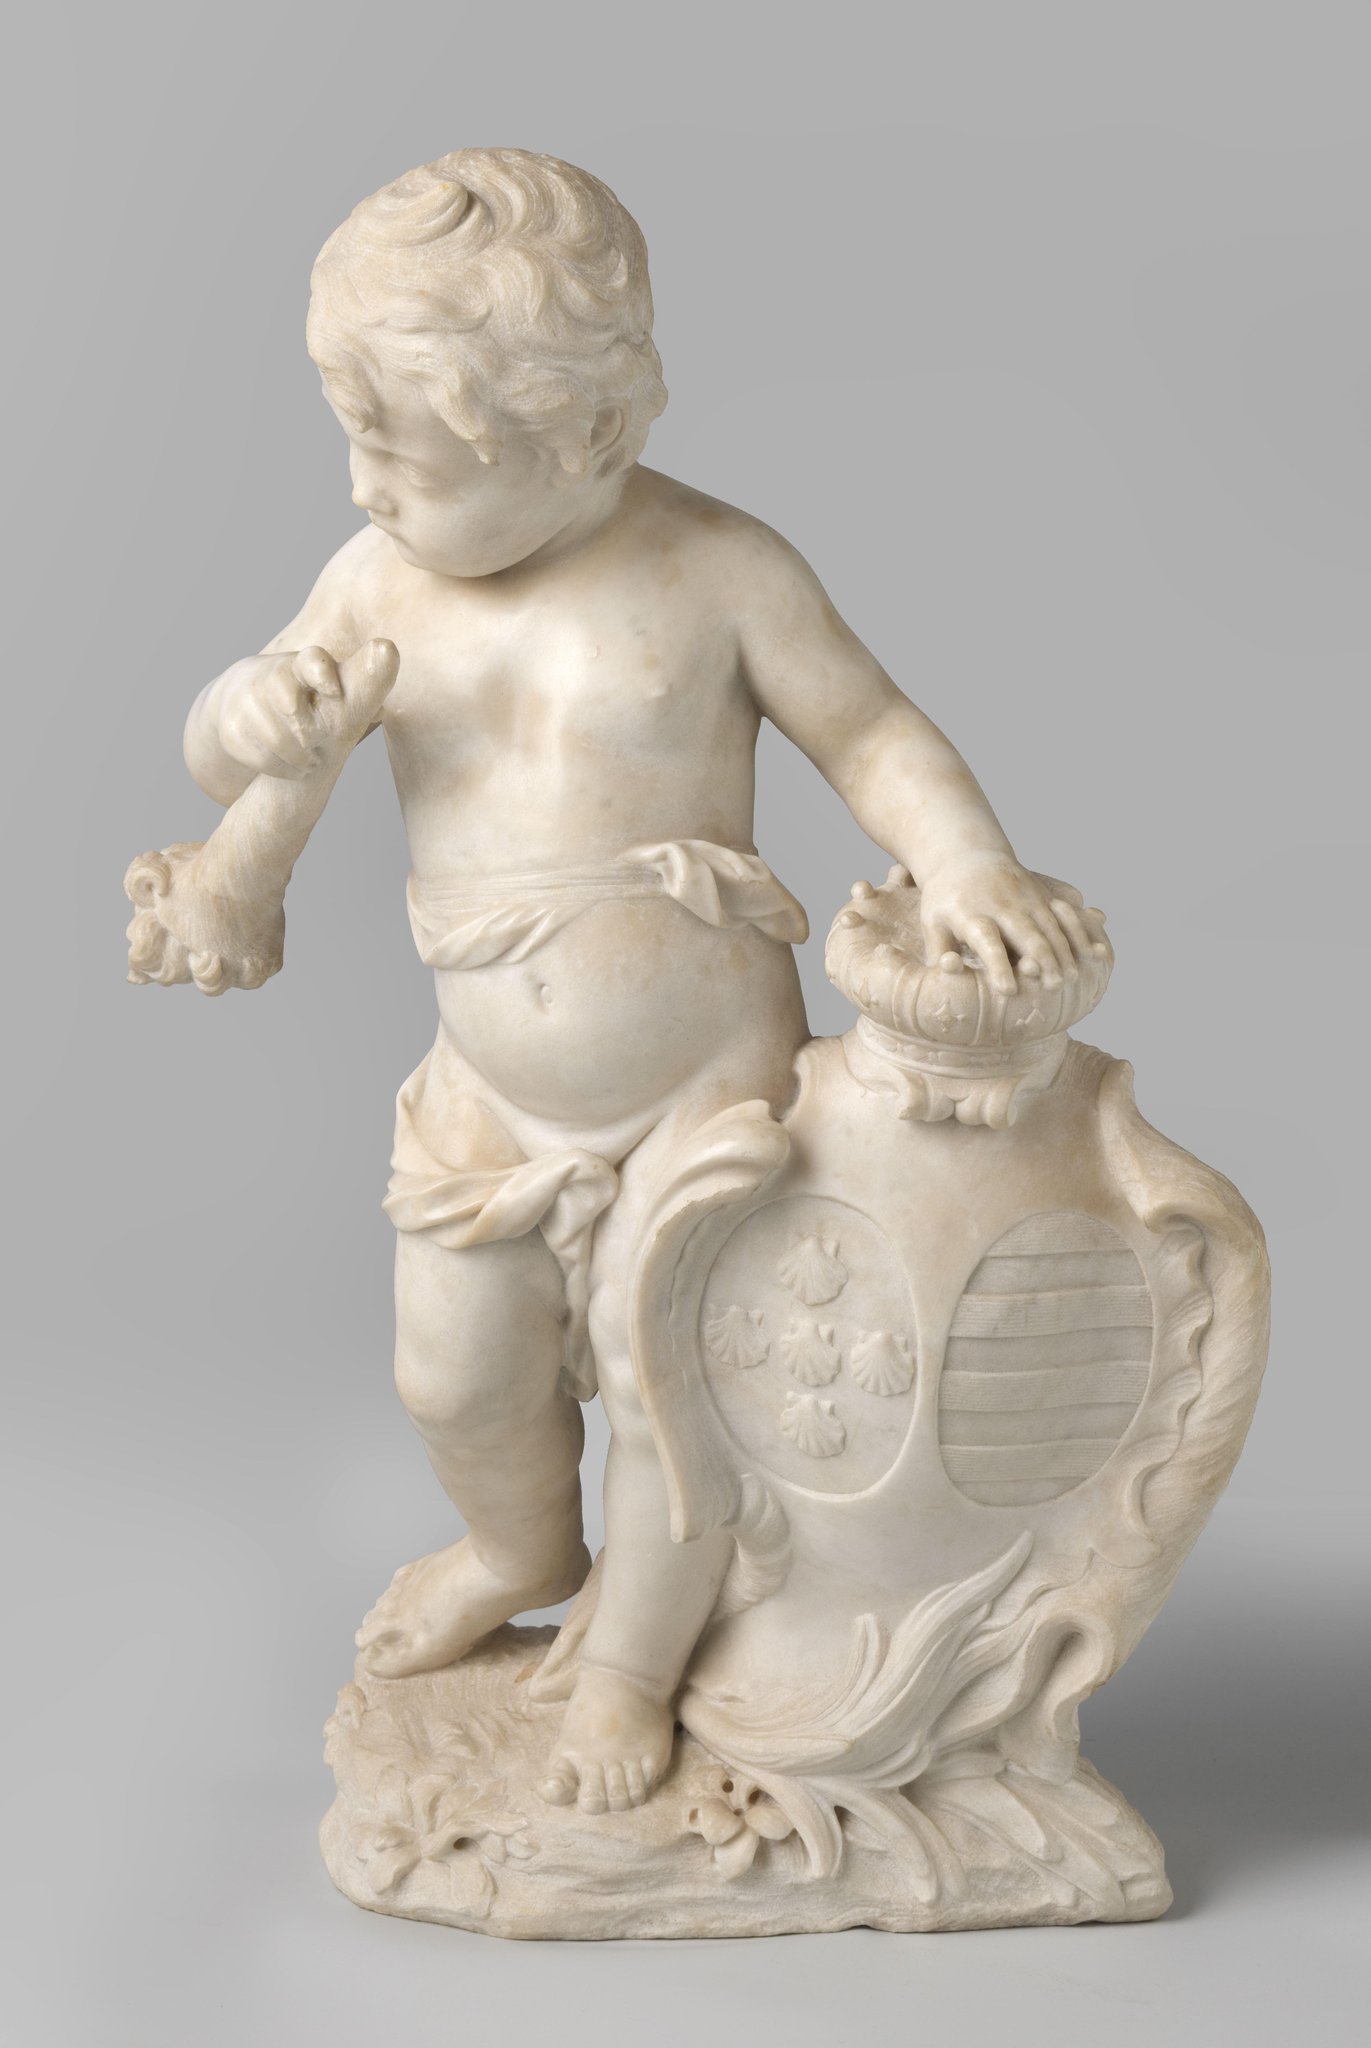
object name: sculpture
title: Marmeren Putti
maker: laurent delvaux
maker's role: sculptor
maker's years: 1696-1778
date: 1746-1748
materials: marble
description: Laurent Delvaux (1696 - 1778). Pallas Athena and two mourning putti. Marble. Nivelles, 1746 - 1748. From the funeral monument to Leonard Matthias van der Noot and Helena Catharina de Jonghe in the former church of the Carmelites in Brussels.